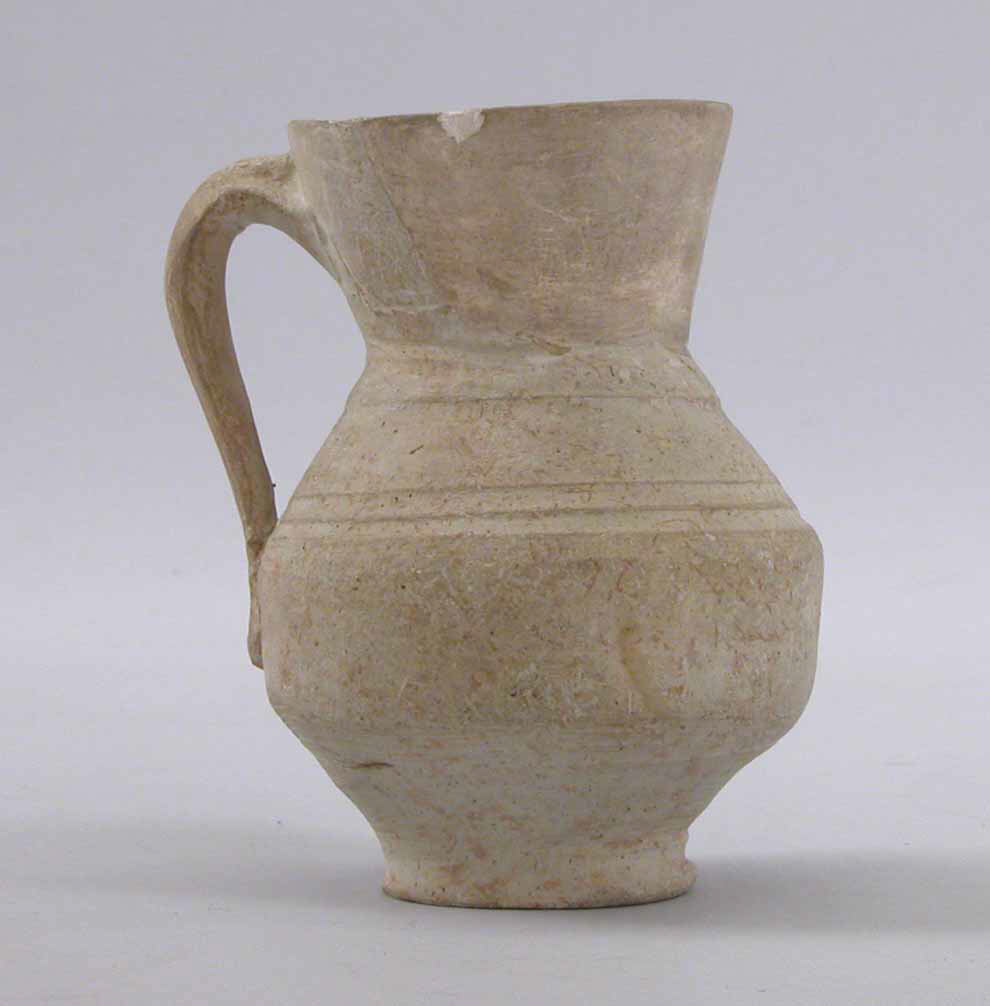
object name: ewer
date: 701-900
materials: earthenware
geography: iran